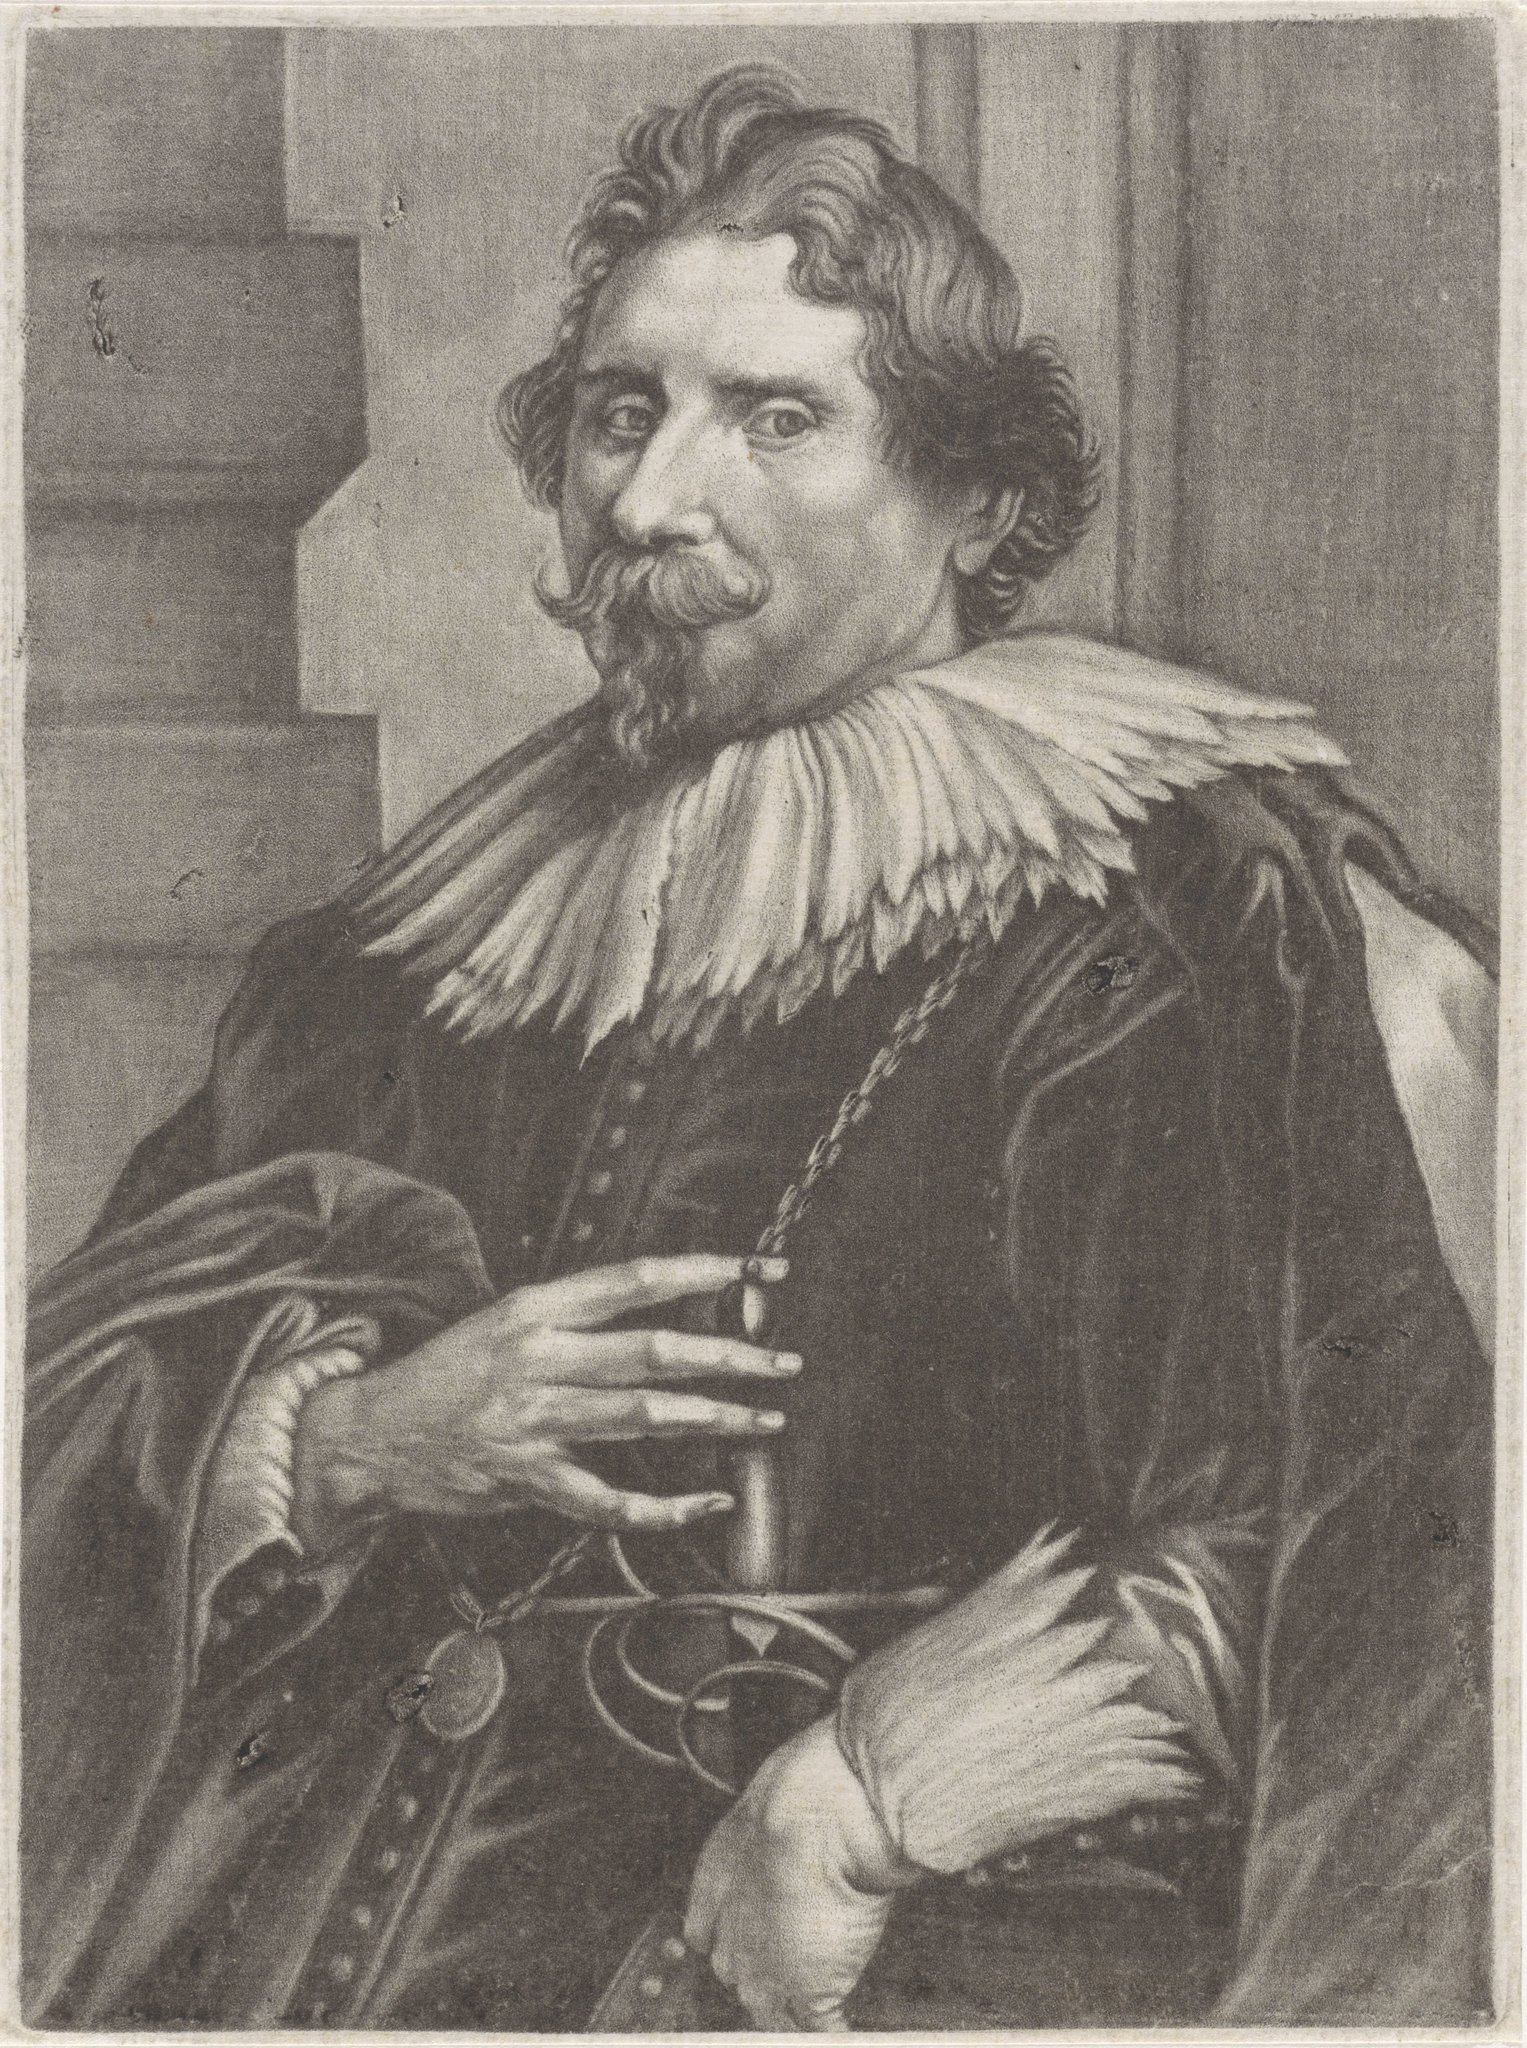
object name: print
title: Portret van Deodat van der Mont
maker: Anonymous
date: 1650-1800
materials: paper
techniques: mezzotint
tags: sint-truiden, antwerp, painter, draughtsman, deodat van der mont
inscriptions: collector's mark: Lugt 2228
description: Deodat van der Mont, schilder te Antwerpen, met zijn rechterhand voor de borst.